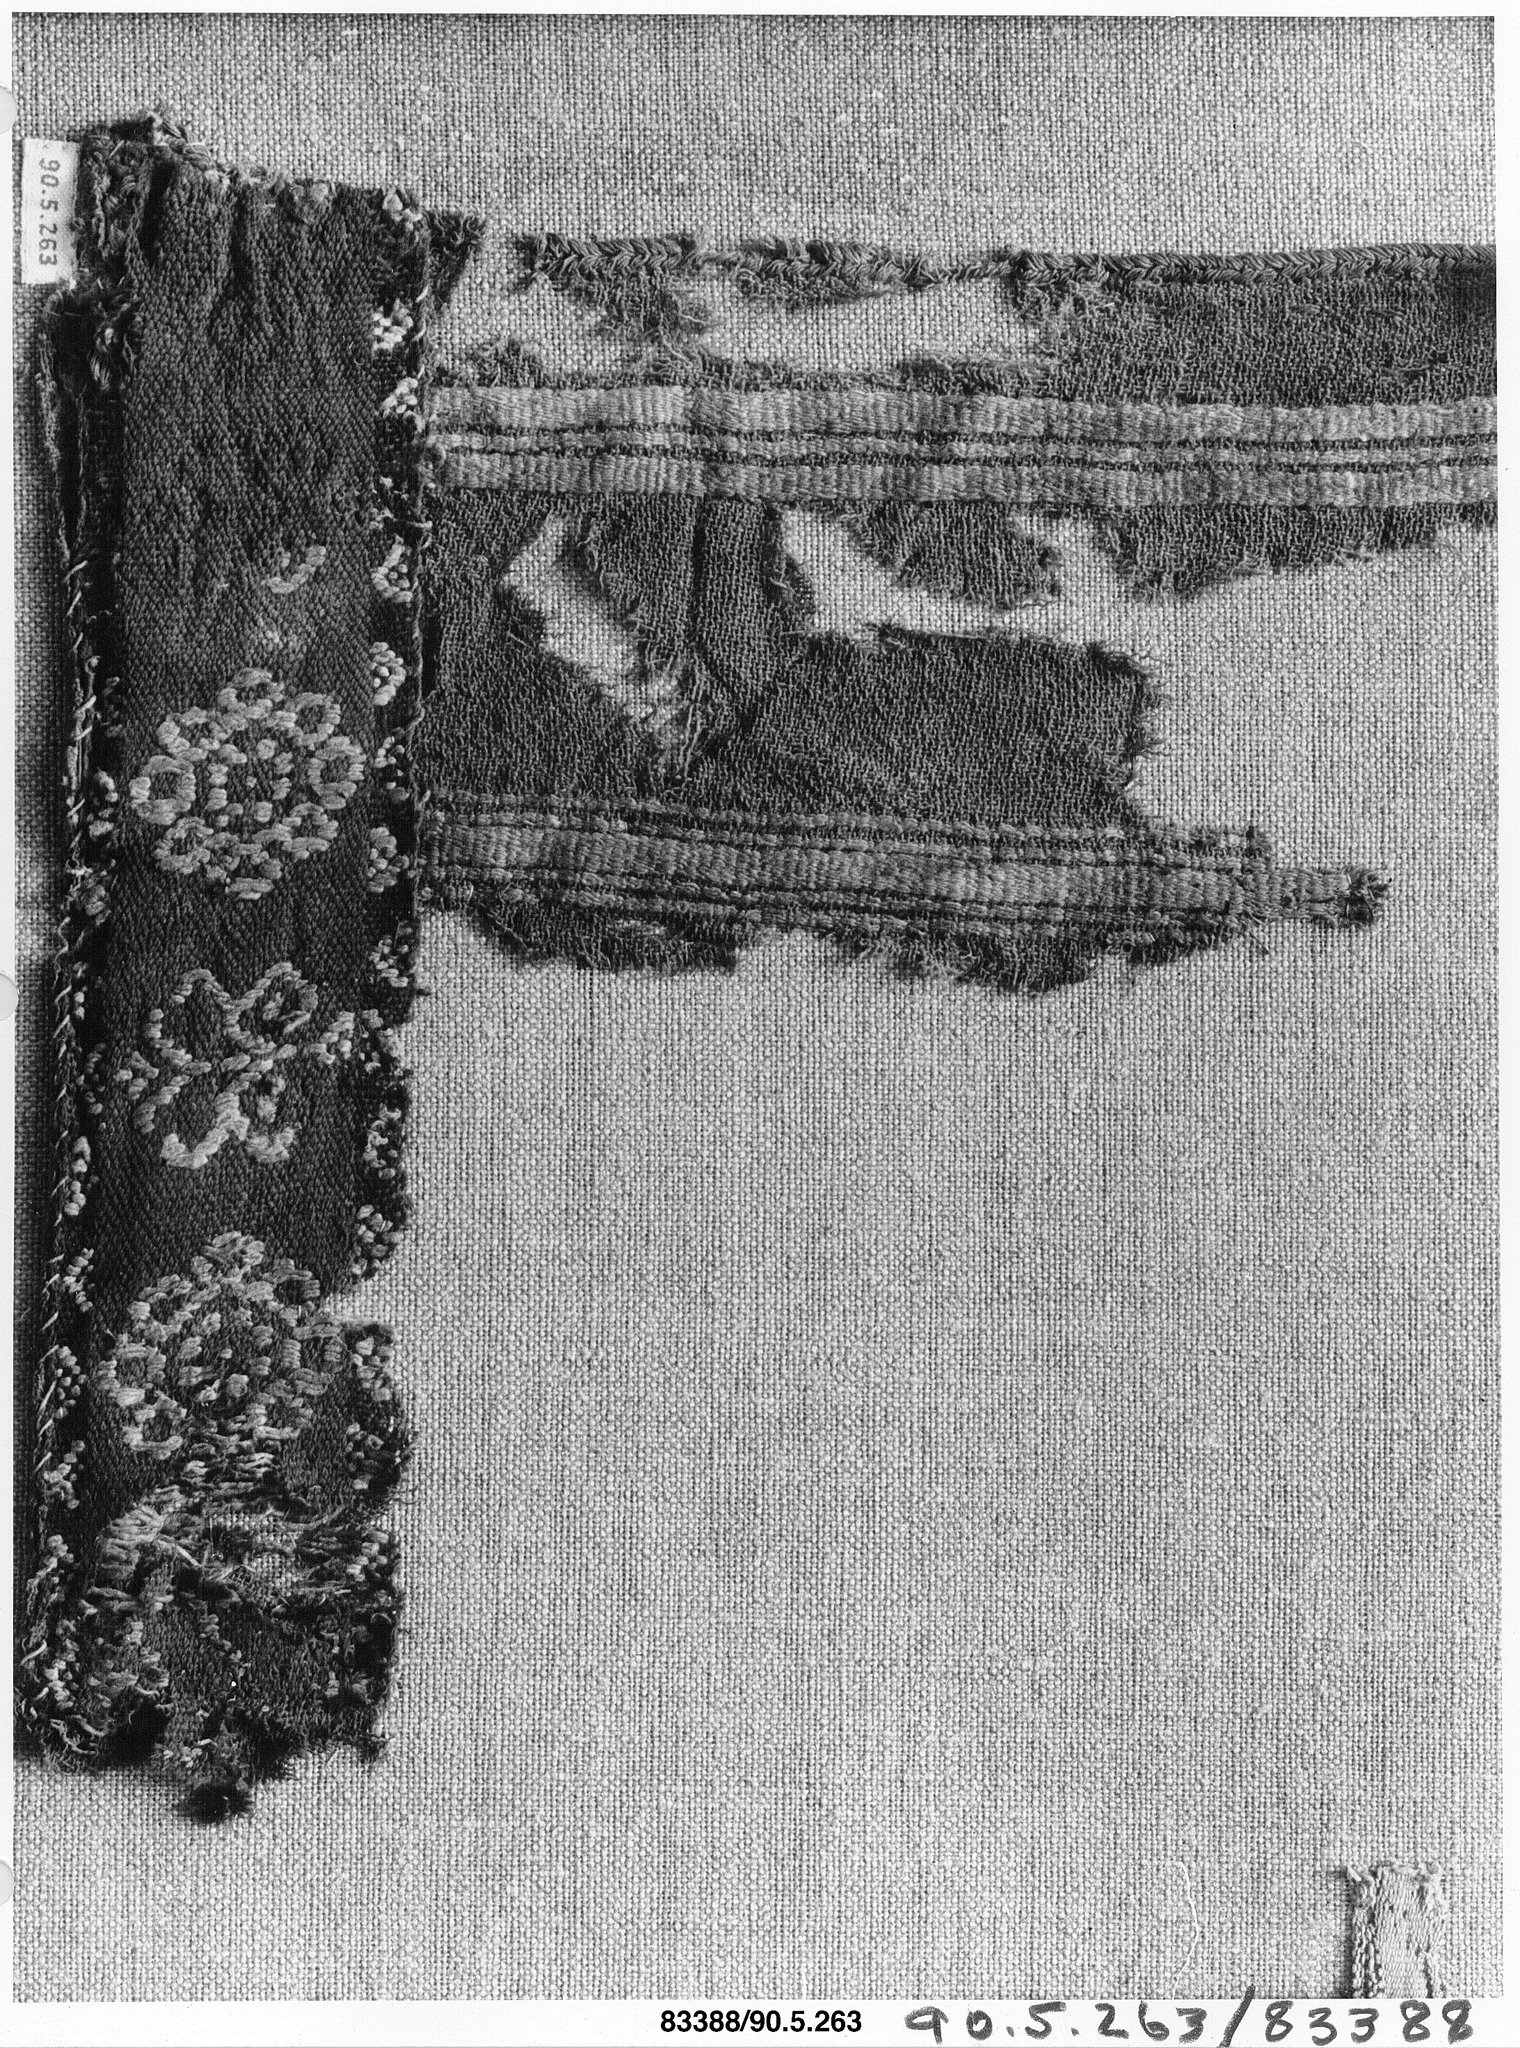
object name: textile fragment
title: Fragment of a Tunic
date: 501-600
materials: linen, wool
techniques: weave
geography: egypt